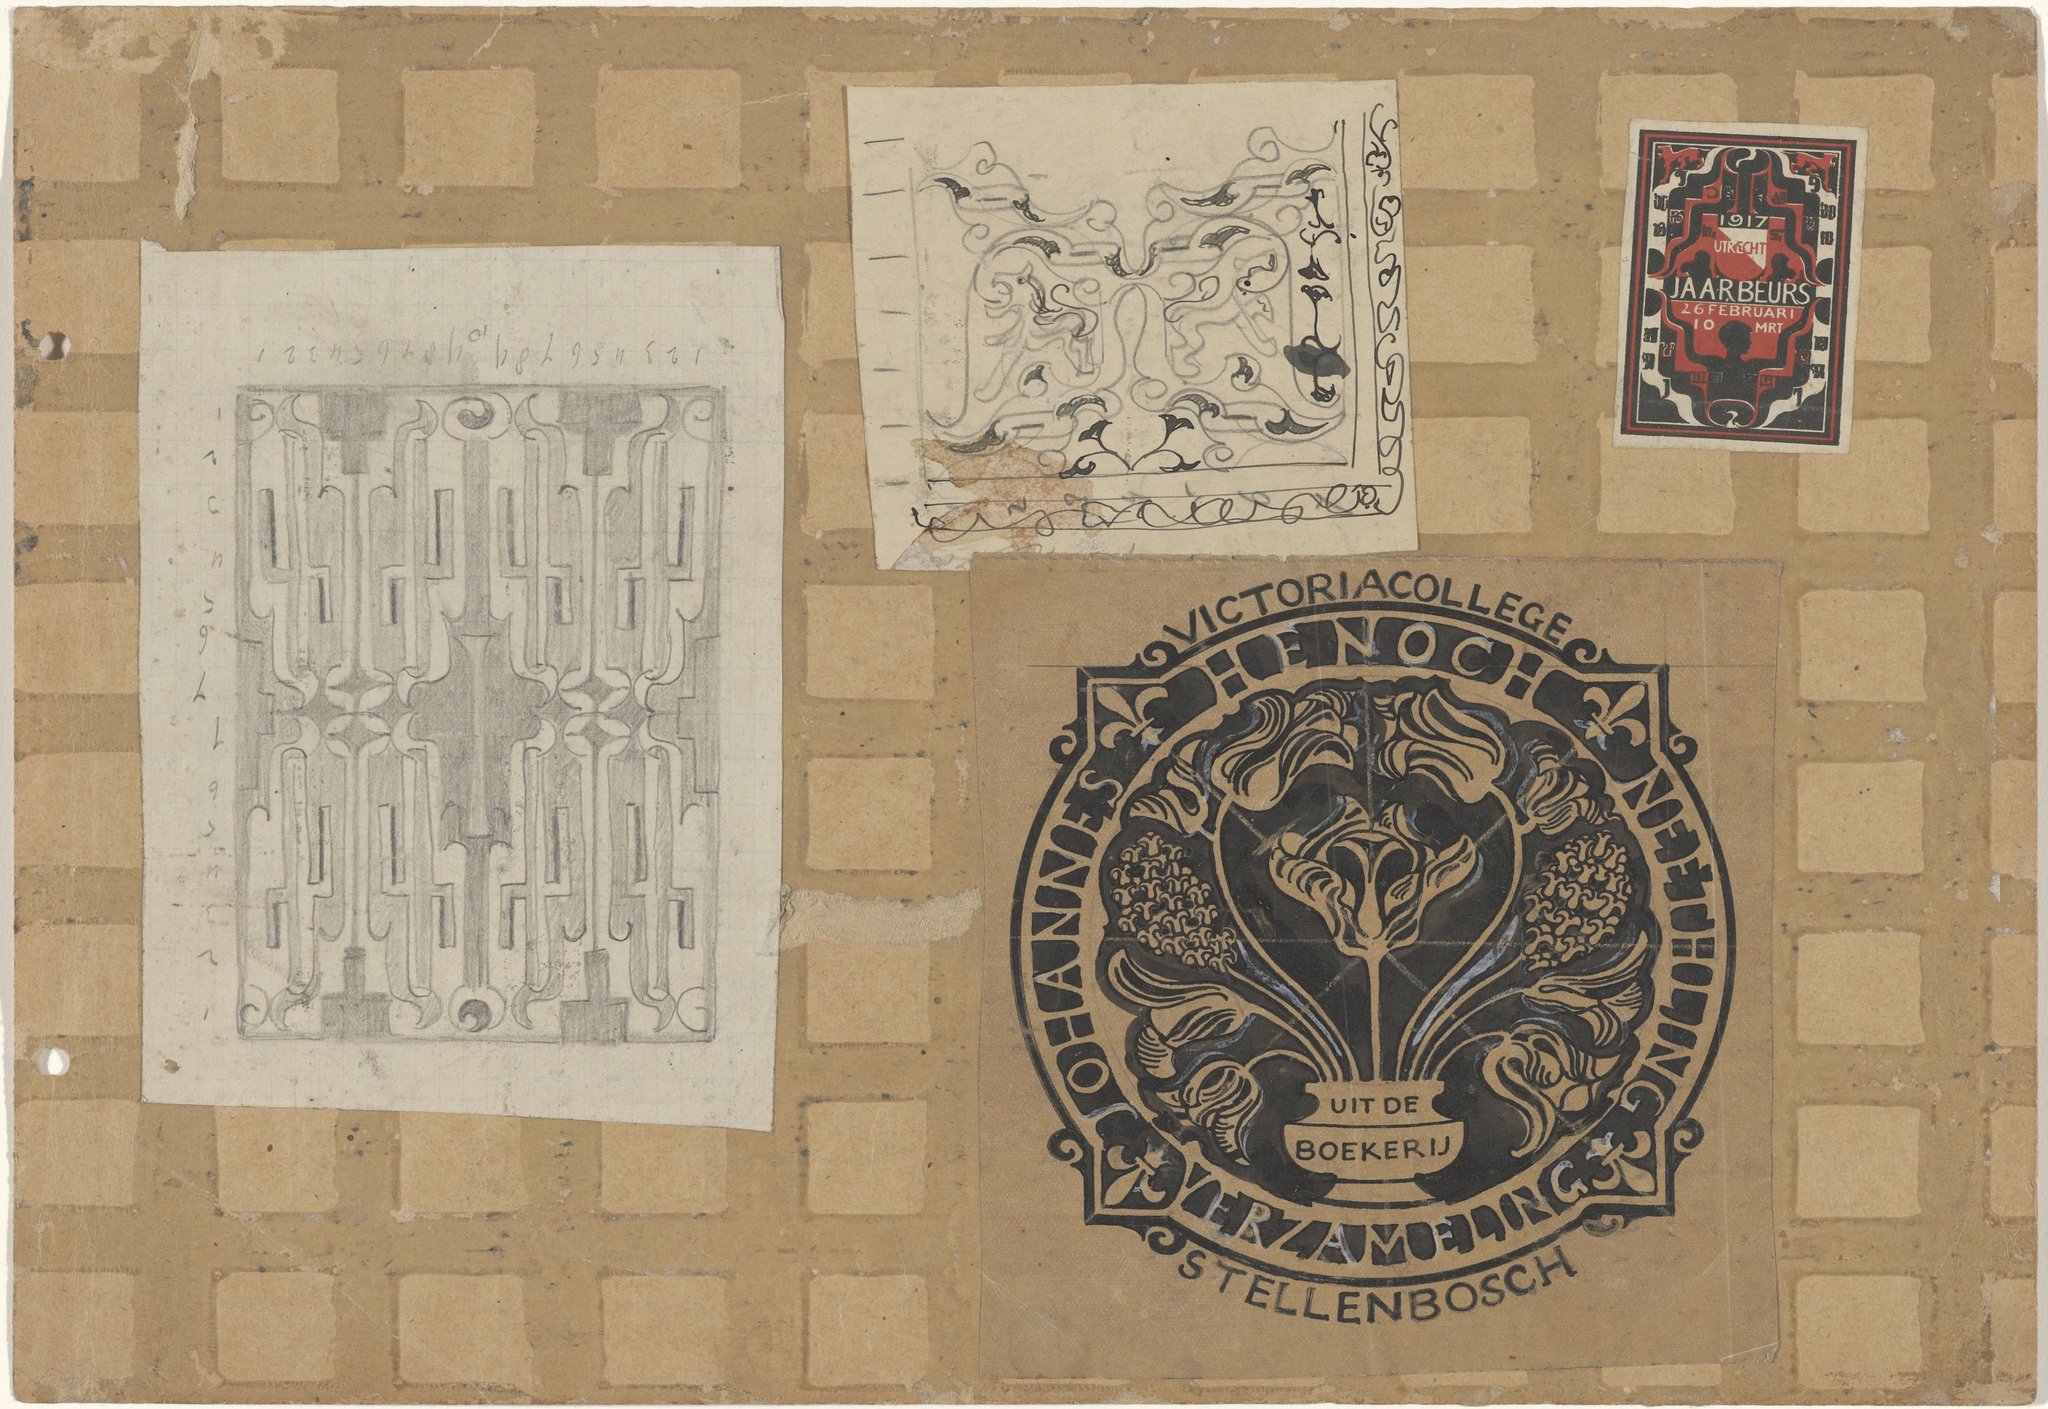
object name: design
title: Ontwerp voor ex libris van Johannes Henoch Neethling, en twee andere ontwerpen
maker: carel adolph lion cachet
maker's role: draughtsman, print maker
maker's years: 1864-1945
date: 1874-1945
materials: paint, ink, paper, pencil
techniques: brush, pen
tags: historical persons, ex-libris